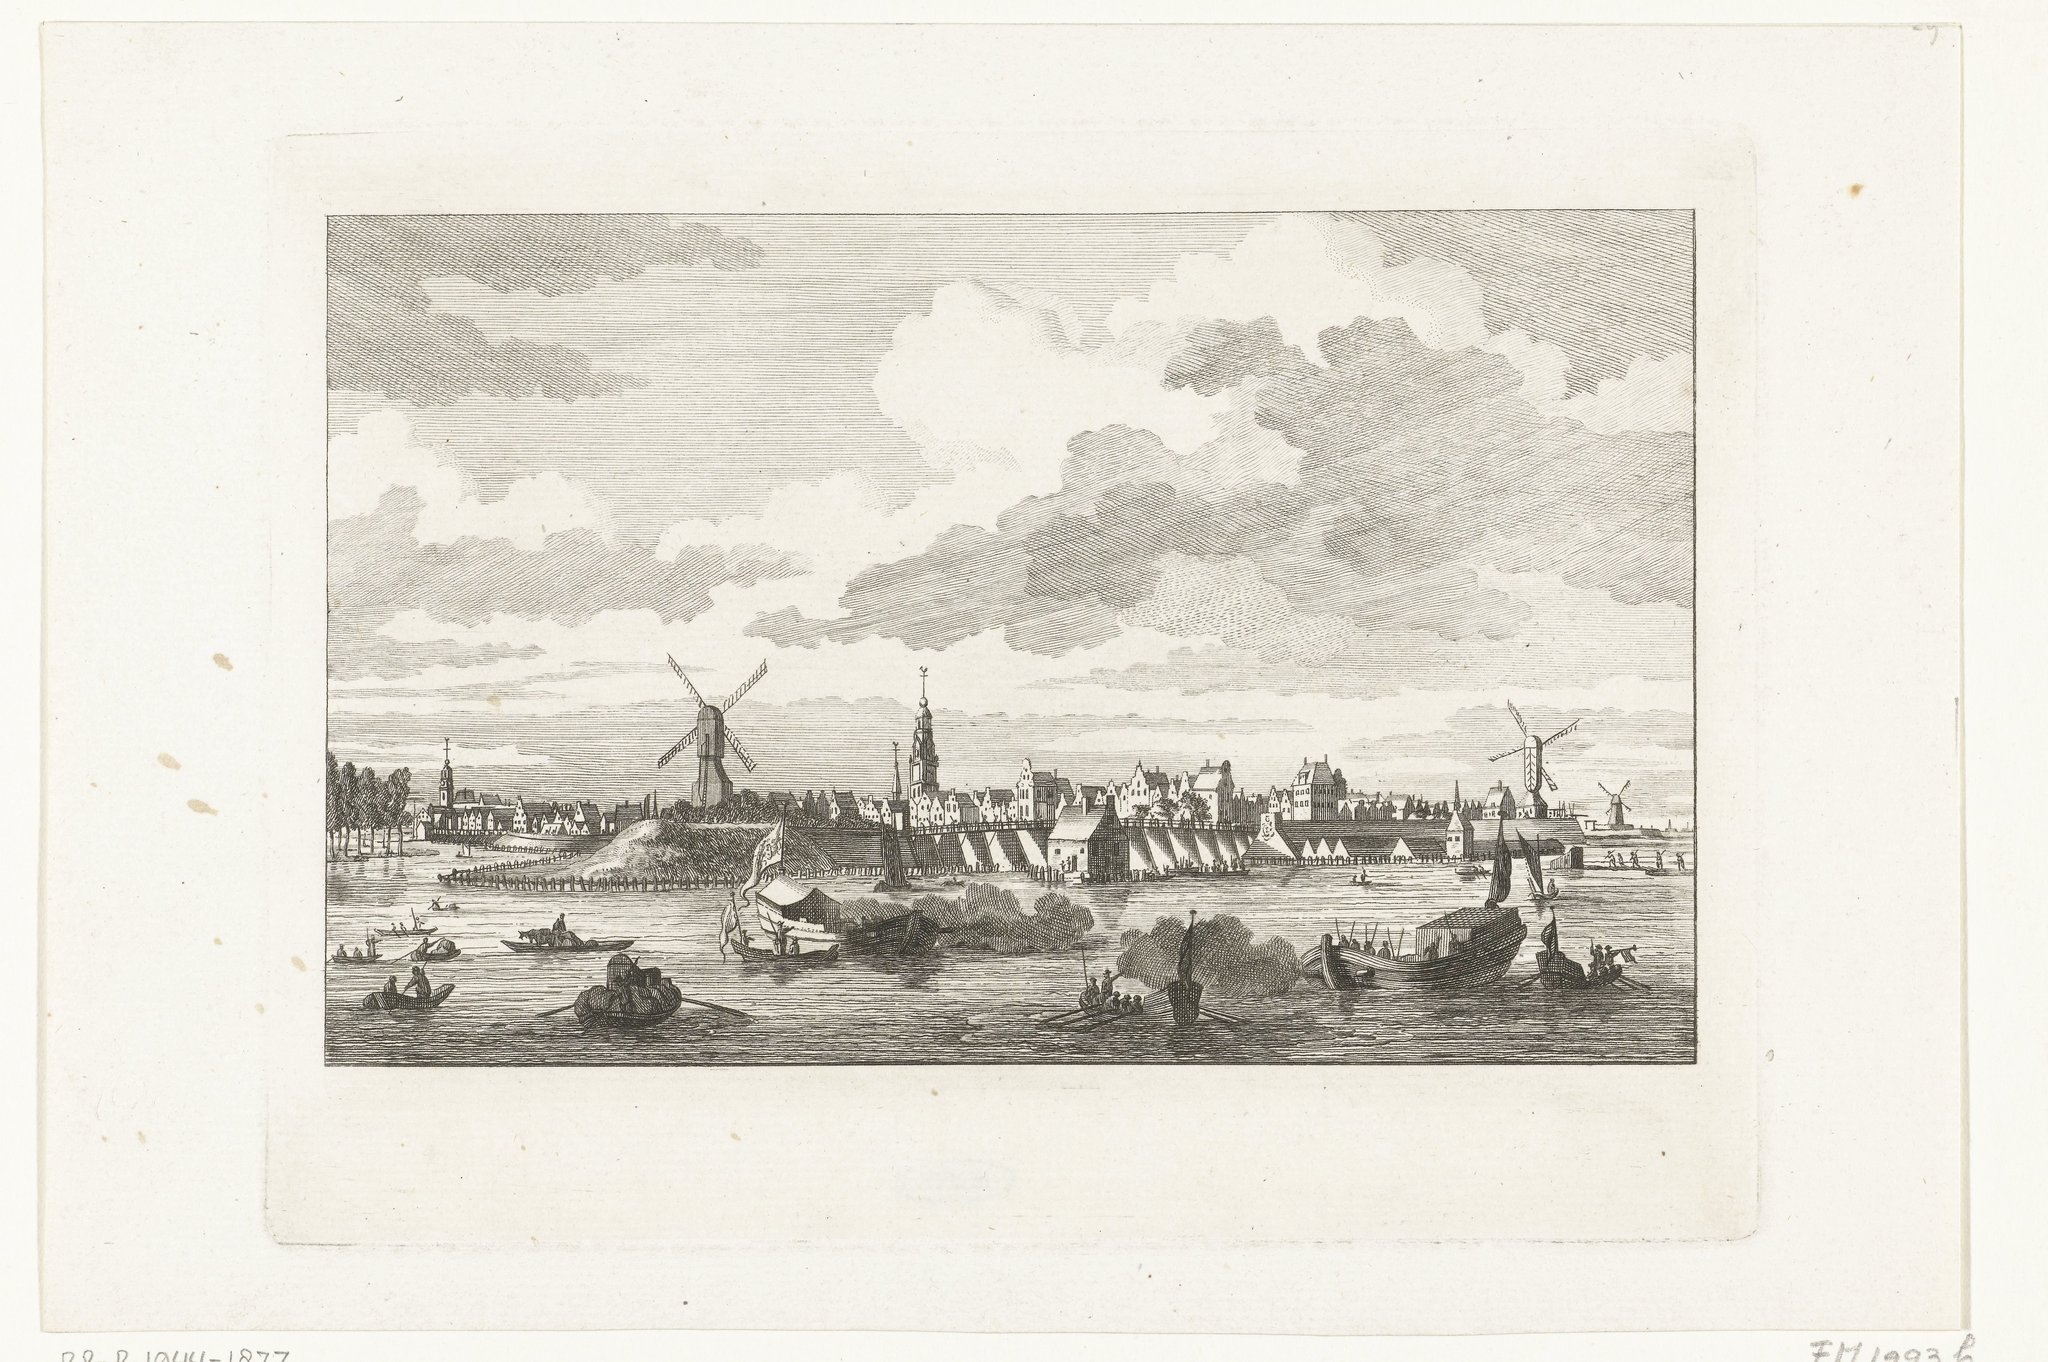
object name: print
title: Gezicht op Amsterdam vanaf de Buiten-Amstel, 1650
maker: j. mijling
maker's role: print maker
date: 1750-1800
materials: paper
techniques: etching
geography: amsterdam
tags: william ii (prince of orange), rowing-boat, canoe, etc., city-walls, prospect of city, town panorama, silhouette of city, amsterdam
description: Gezicht op Amsterdam, gezien vanaf de Buiten-Amstel, zonder de Blokhuizen, 29 juli 1650 (rond de Aanslag op Amsterdam). Met verschillende bootjes (met soldaten of schutters?) op het water. Op de achtergrond de Blauwbrug en de toren van de Zuiderkerk.